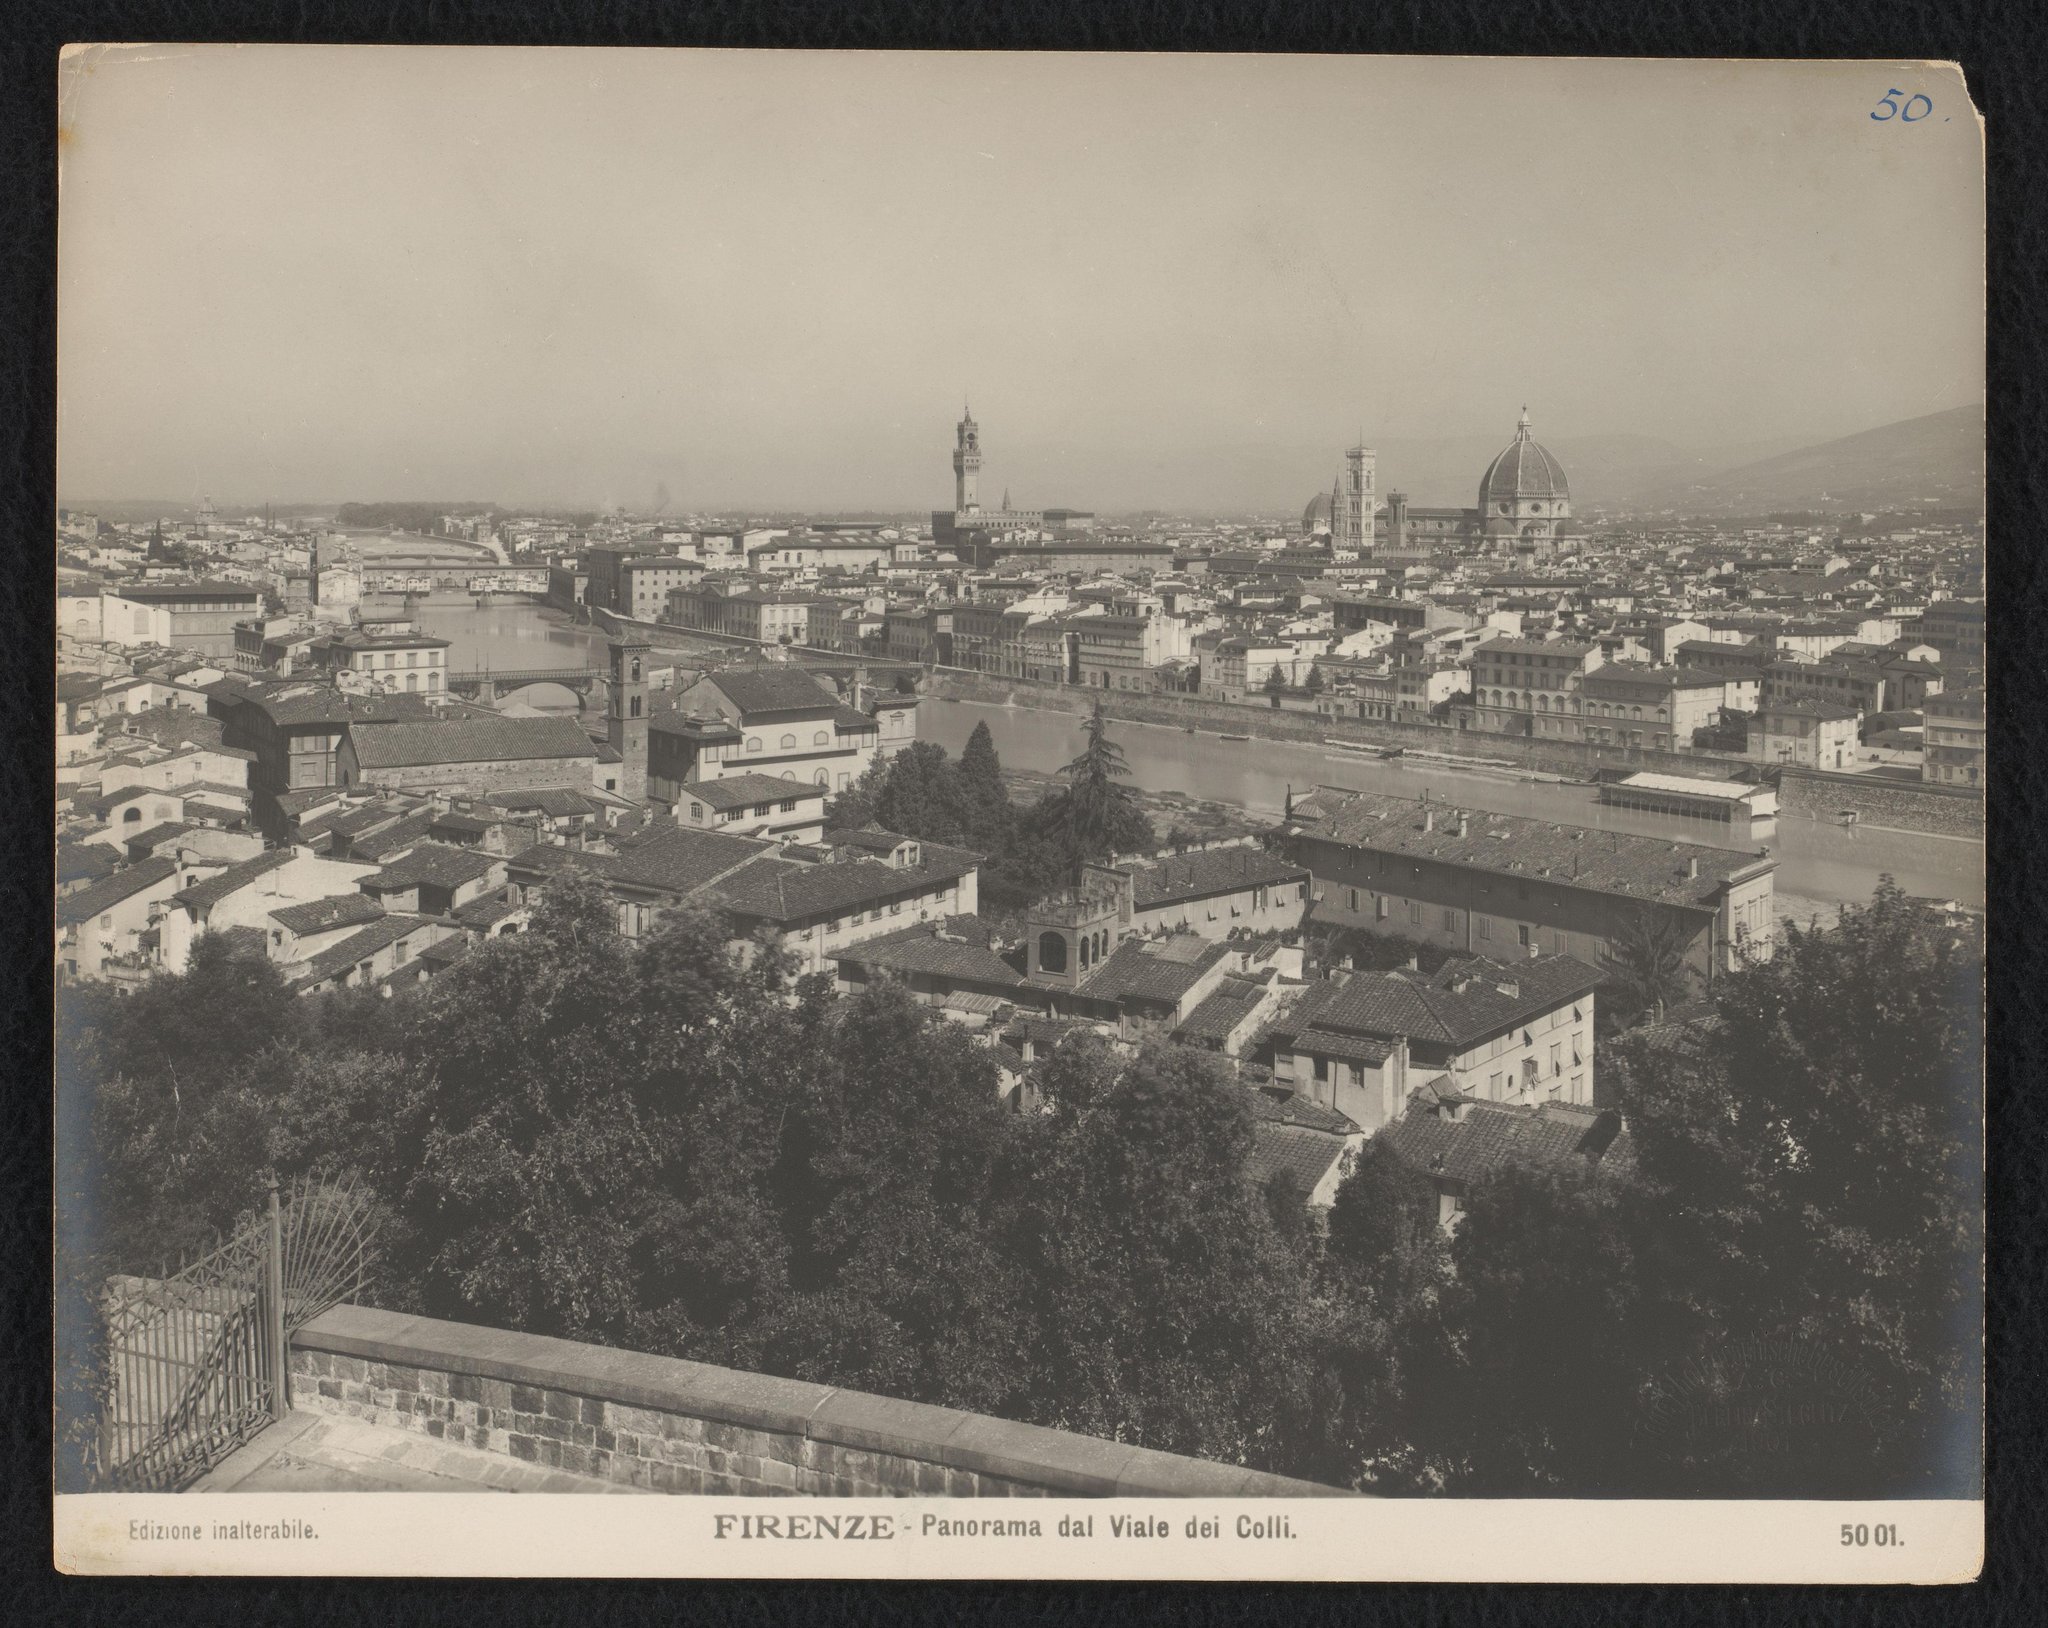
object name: photograph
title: Firenze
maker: Anonymous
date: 1901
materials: paper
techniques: gelatin silver print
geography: florence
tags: city-view in general; 'veduta'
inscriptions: number: ‘50.’, inscription: ‘Edizione inalterabile.’, number: ‘5001’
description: Deze foto maakt deel uit van een omslag.